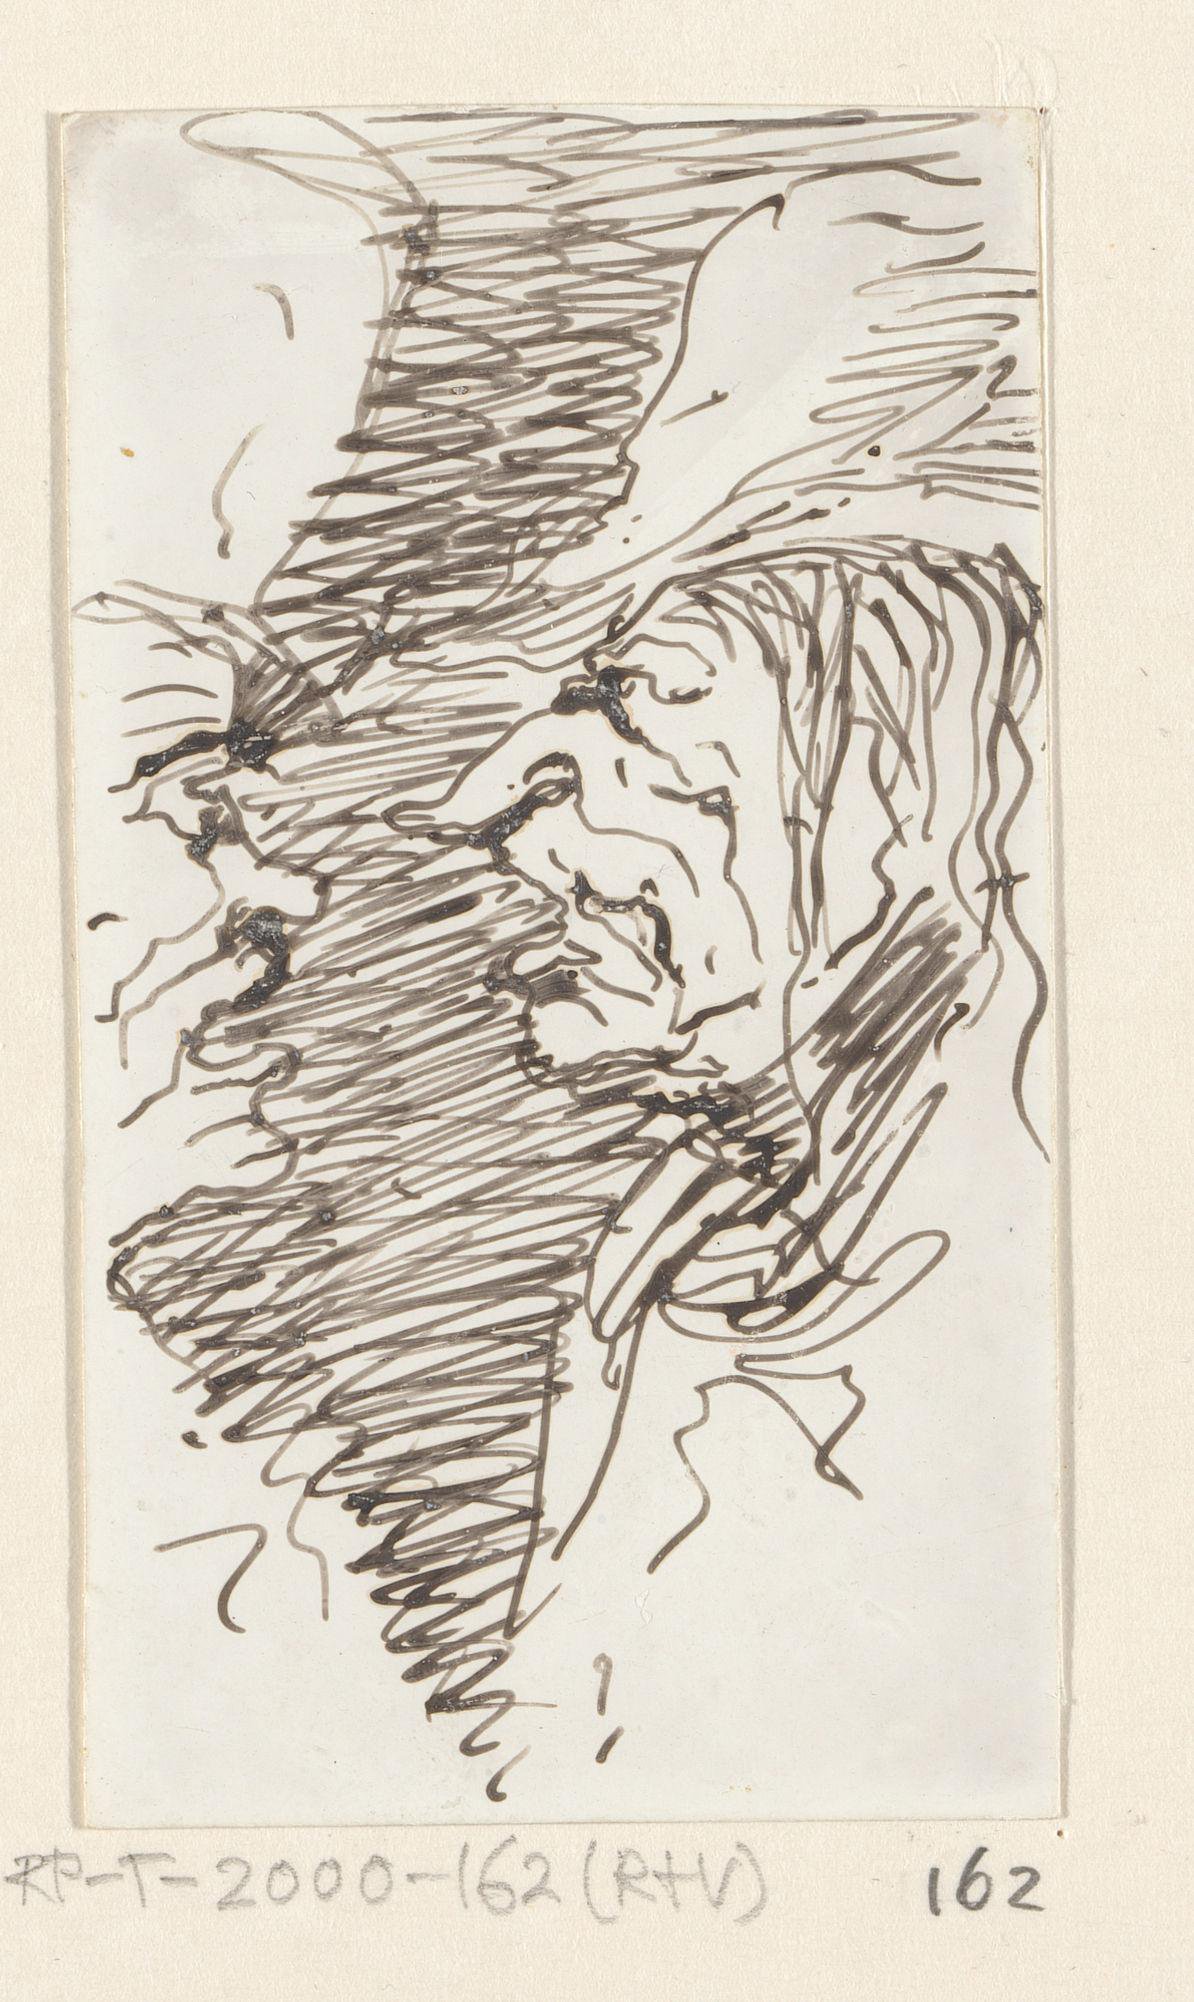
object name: visiting card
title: Koppen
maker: johannes tavenraat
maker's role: draughtsman, painter, print maker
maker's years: 1809-1881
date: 1870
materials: ink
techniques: pen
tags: caricatures (human types)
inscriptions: collector's mark: Lugt 2228, signature and date: ‘Tavenraat - 1/1 1870’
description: Twee karikaturale koppen, getekend op de keerzijde van het visitekaartje van: 'A. van Savoyen'.